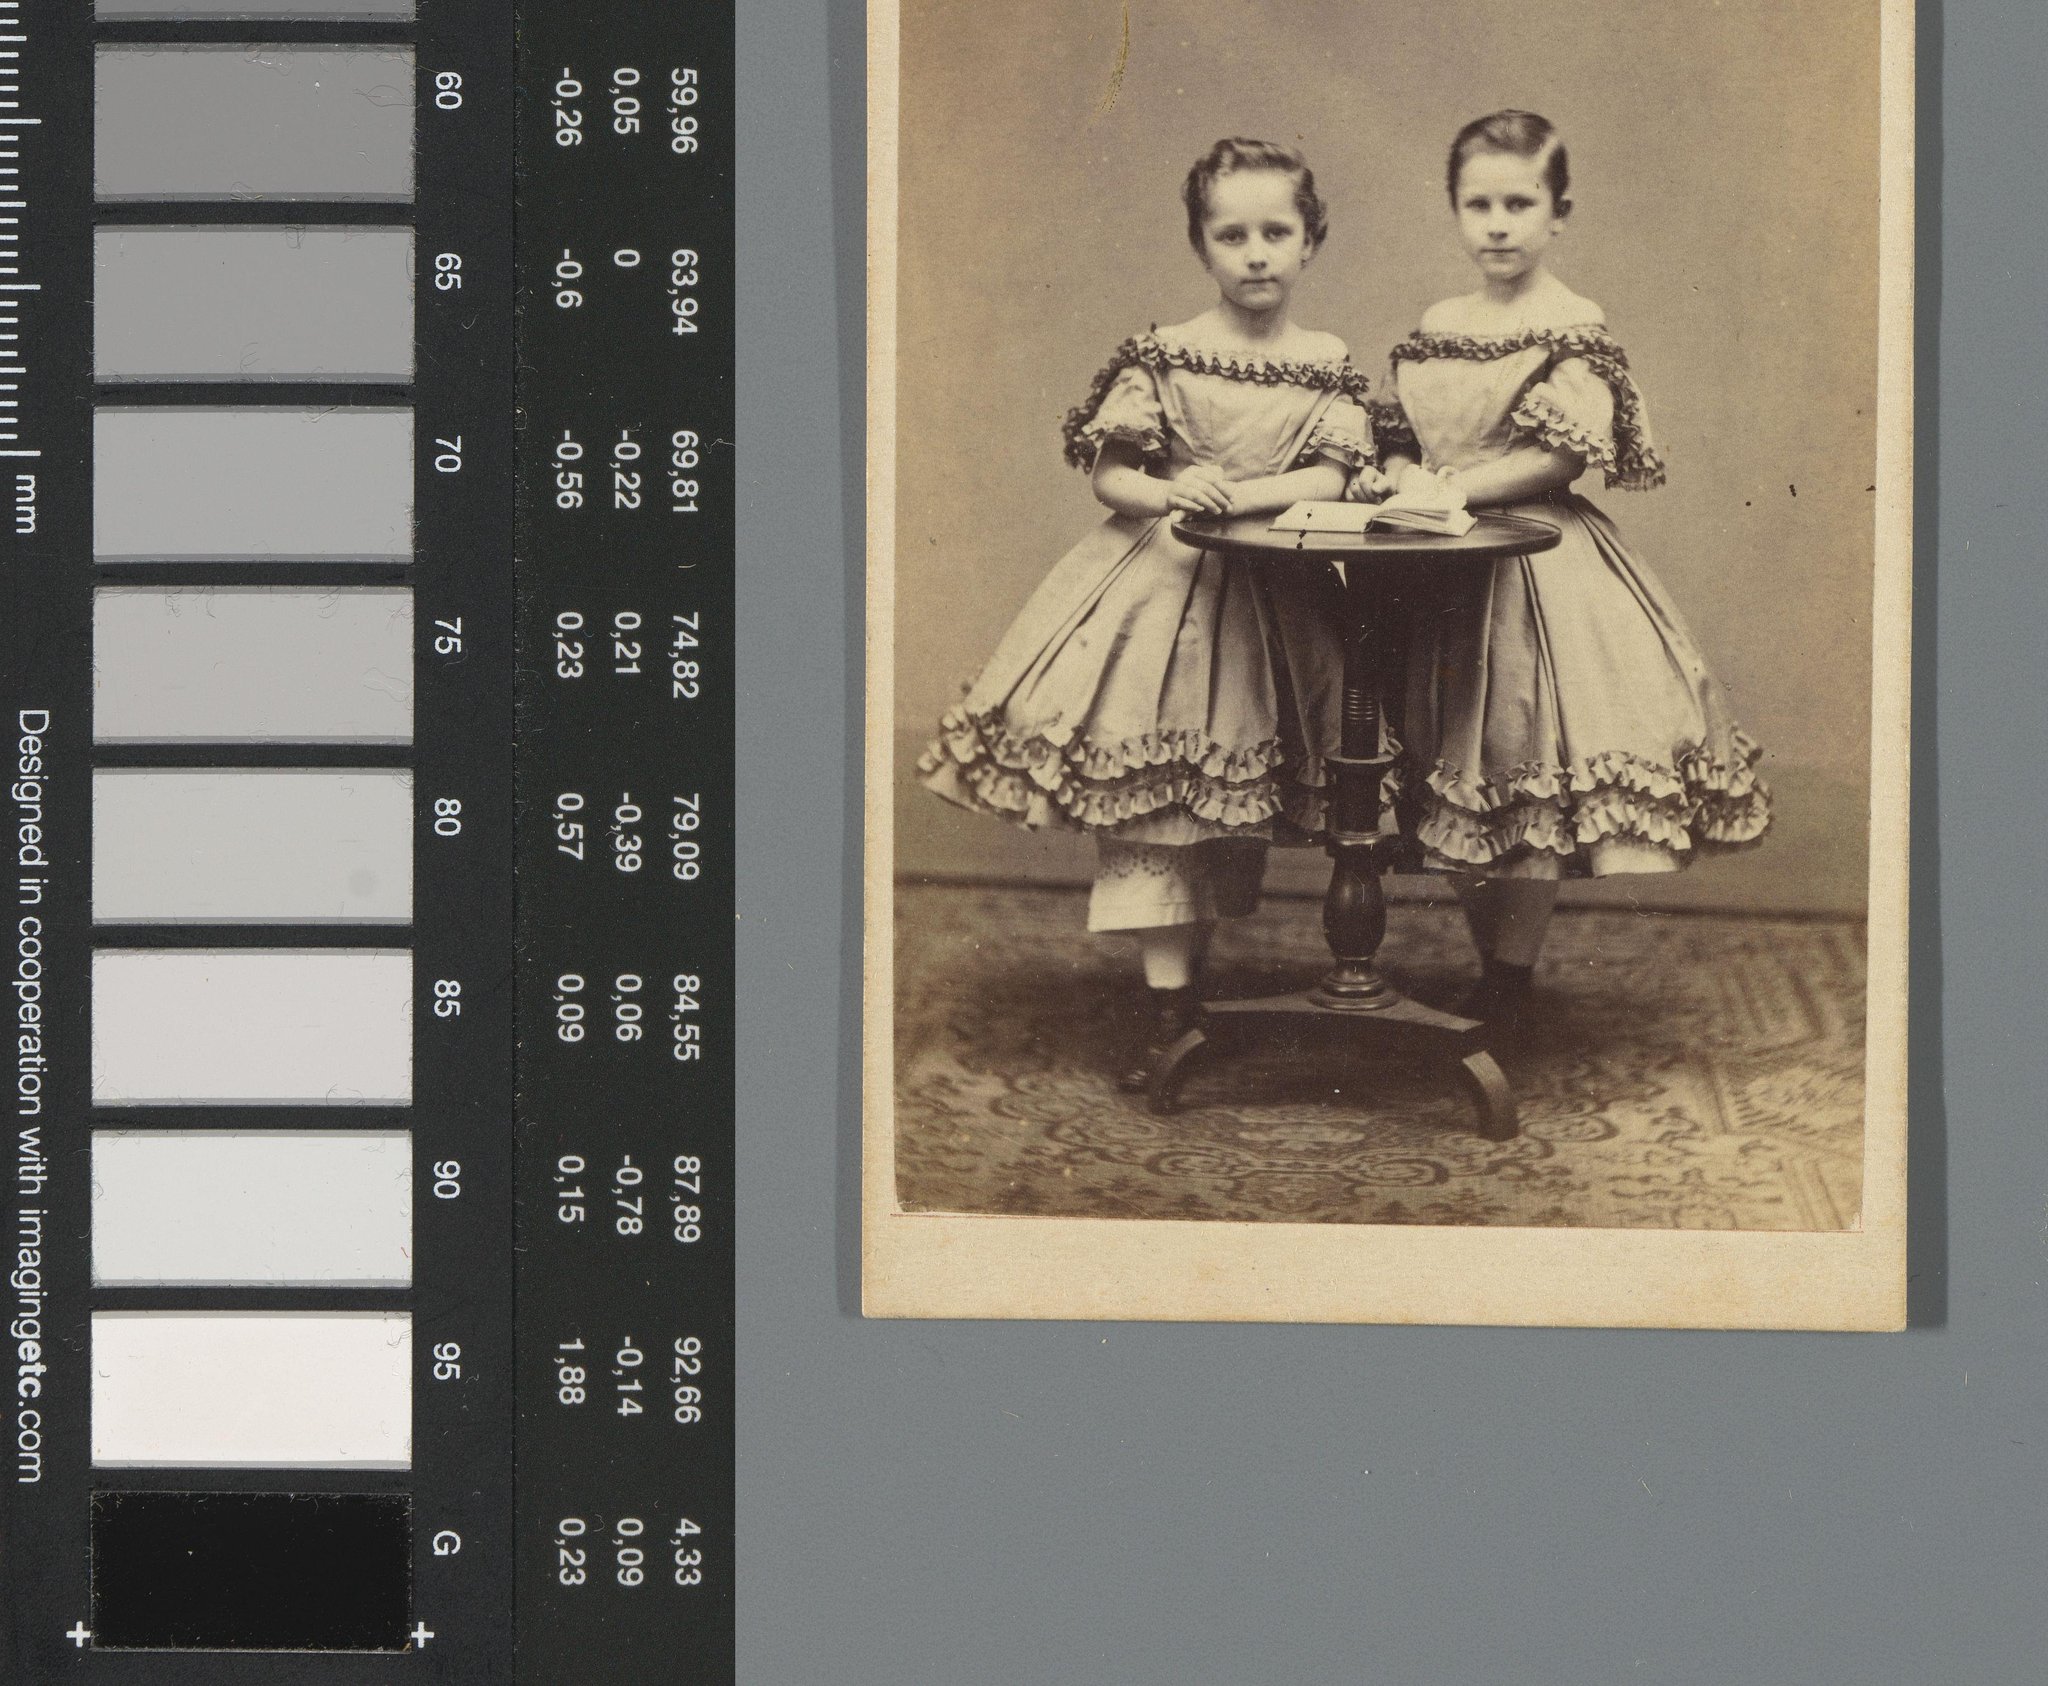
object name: photograph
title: Portret van Joanna en Goverta Teding van Berkhout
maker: willem tinker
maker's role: fotograaf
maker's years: 1816-1894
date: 1860-1866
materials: cardboard, photographic support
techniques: photography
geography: haarlem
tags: historical persons - bb - woman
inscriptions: annotation: ‘Jet de Clercq-TvB en Go Haitsma Mulier TvB’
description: Volgens het opschrift op de achterzijde van de foto zou het gaan om de zusjes Jet (Henriette) en Go (Goverta). Het is echter waarschijnlijker dat het de zusjes Joanna en Go betreft (vgl. het portret van Jet RP-F-2015-10-333 gelijktijdig in dezelfde studio gemaakt).